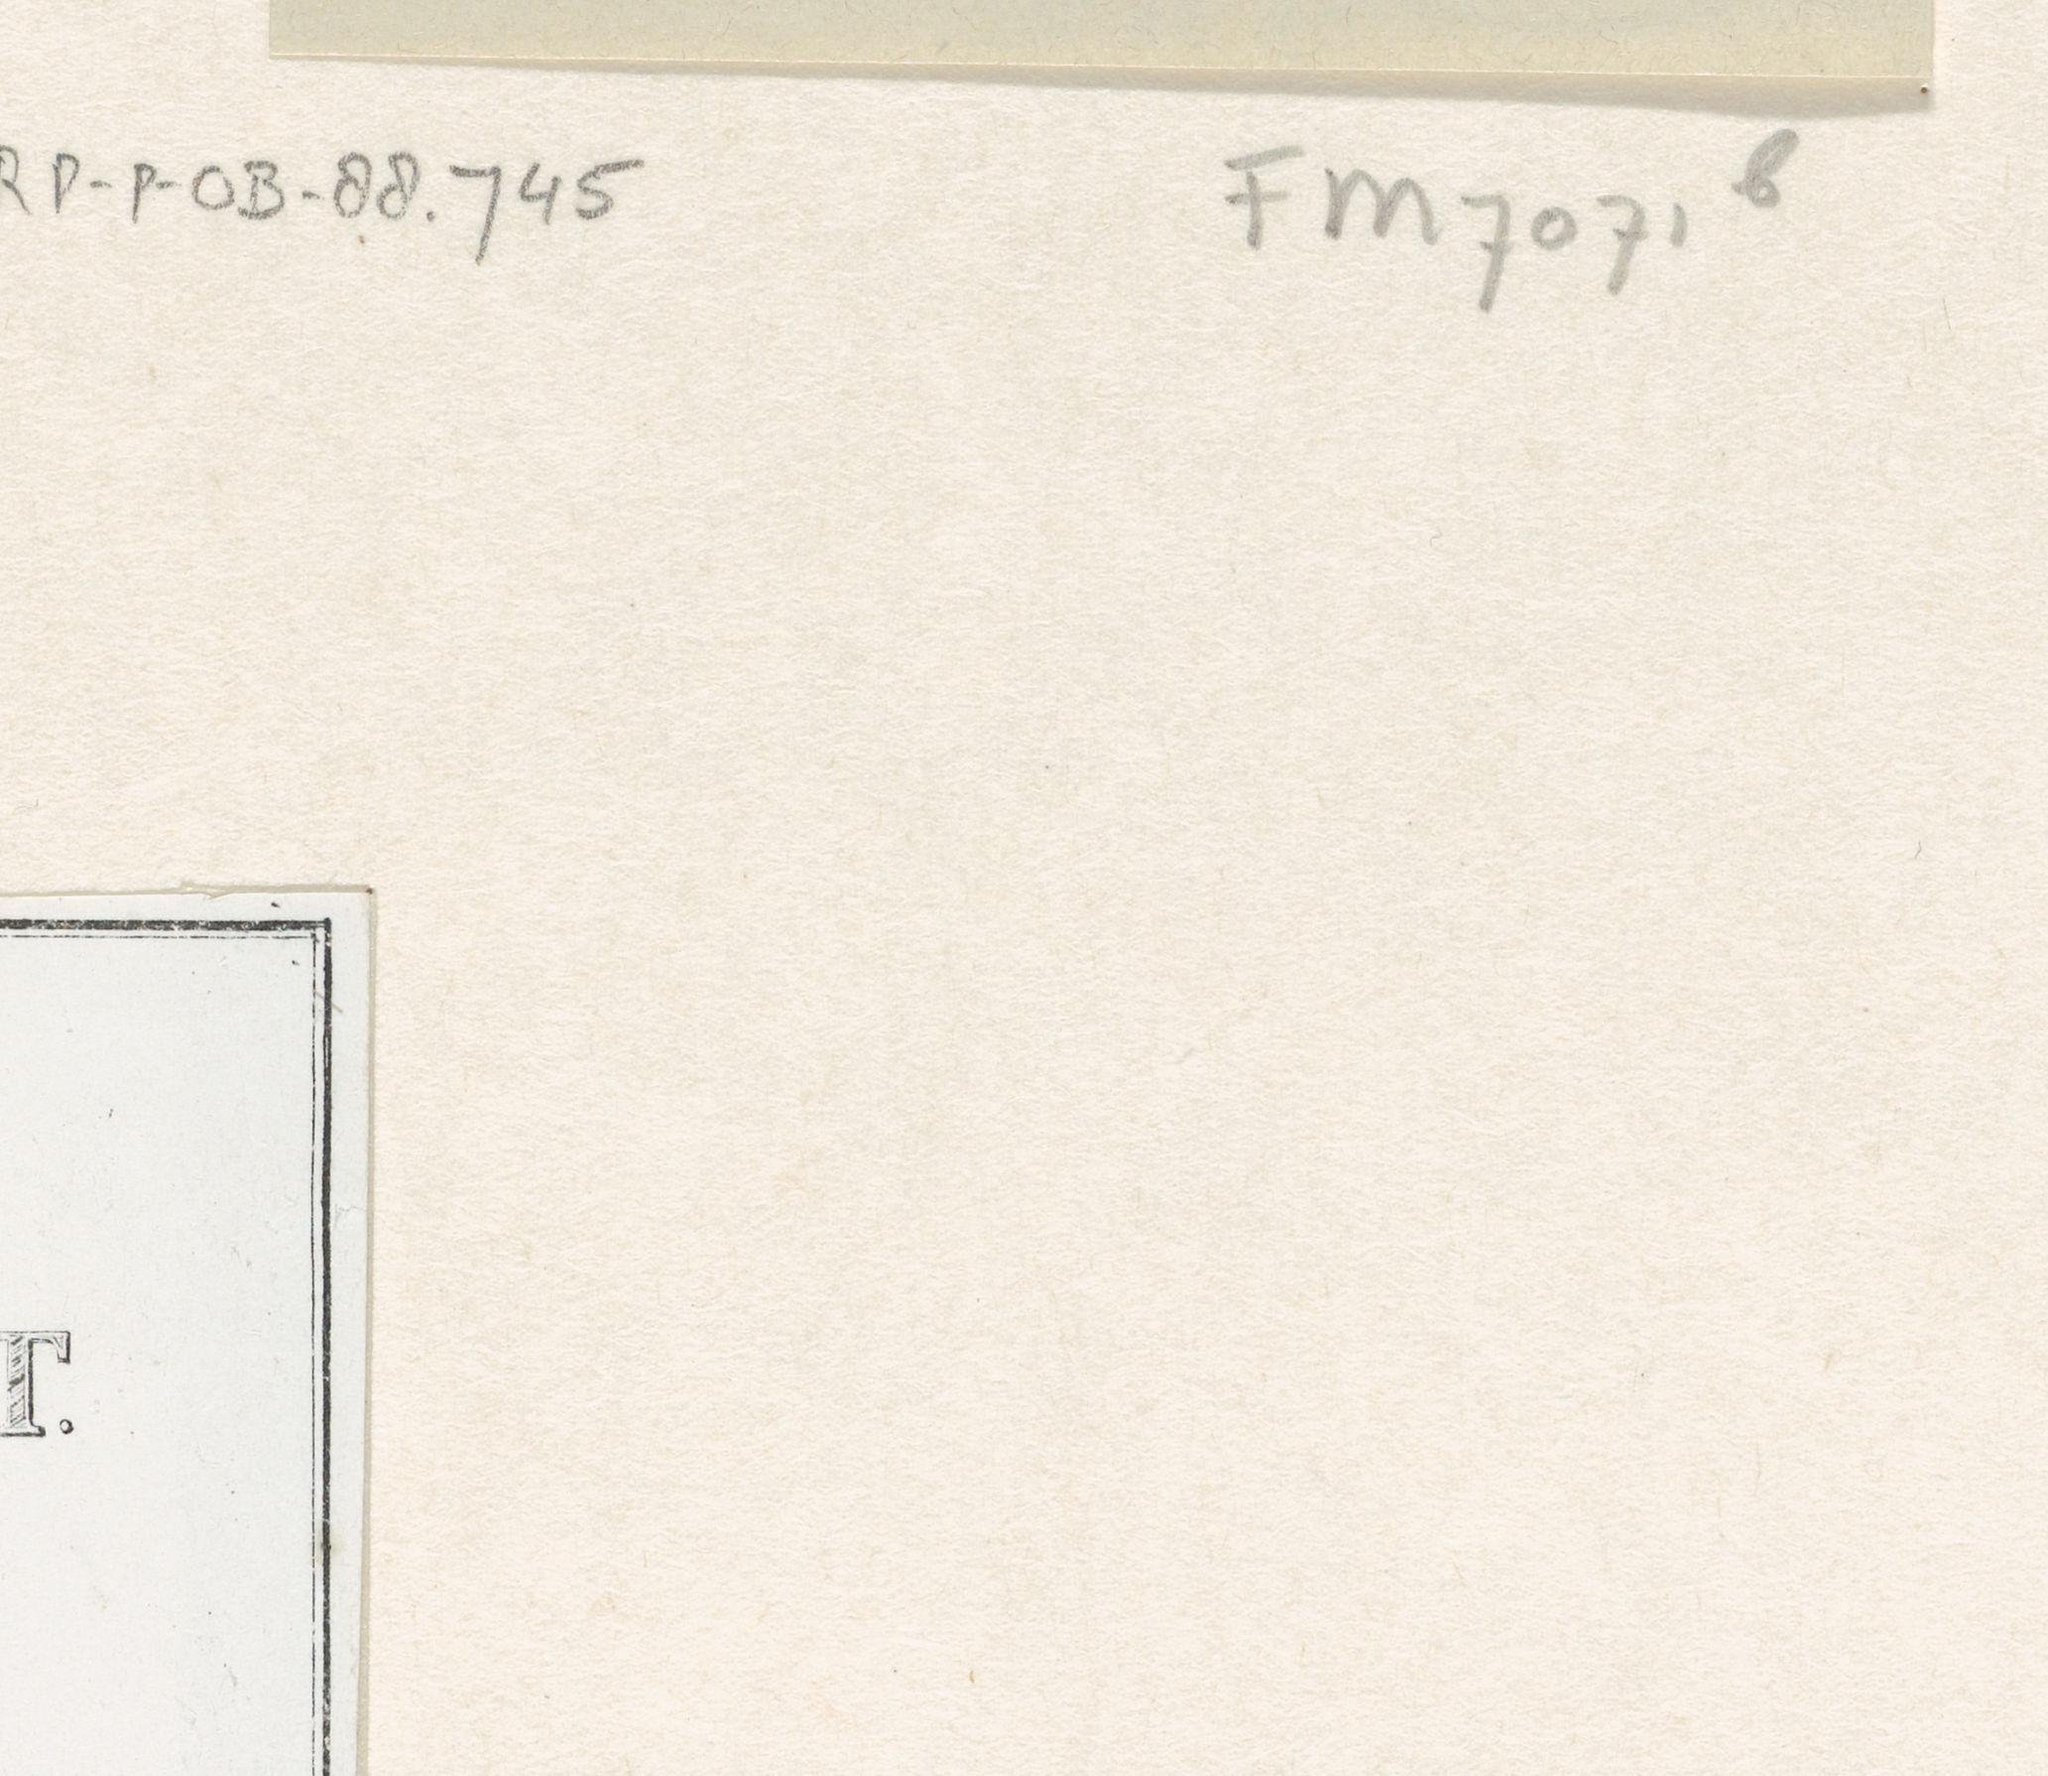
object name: print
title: Standbeeld van Willem de Zwijger, ca. 1850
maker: Anonymous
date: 1850-1875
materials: paper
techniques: letterpress printing, engraving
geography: netherlands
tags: delft, william i (prince of orange), monument, statue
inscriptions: collector's mark: Lugt 2228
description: Standbeeld van Willem van Oranje van Louis Royer op het Plein in Den Haag, ca. 1850. Op de achterzijde bedrukt met een vers over Erasmus.